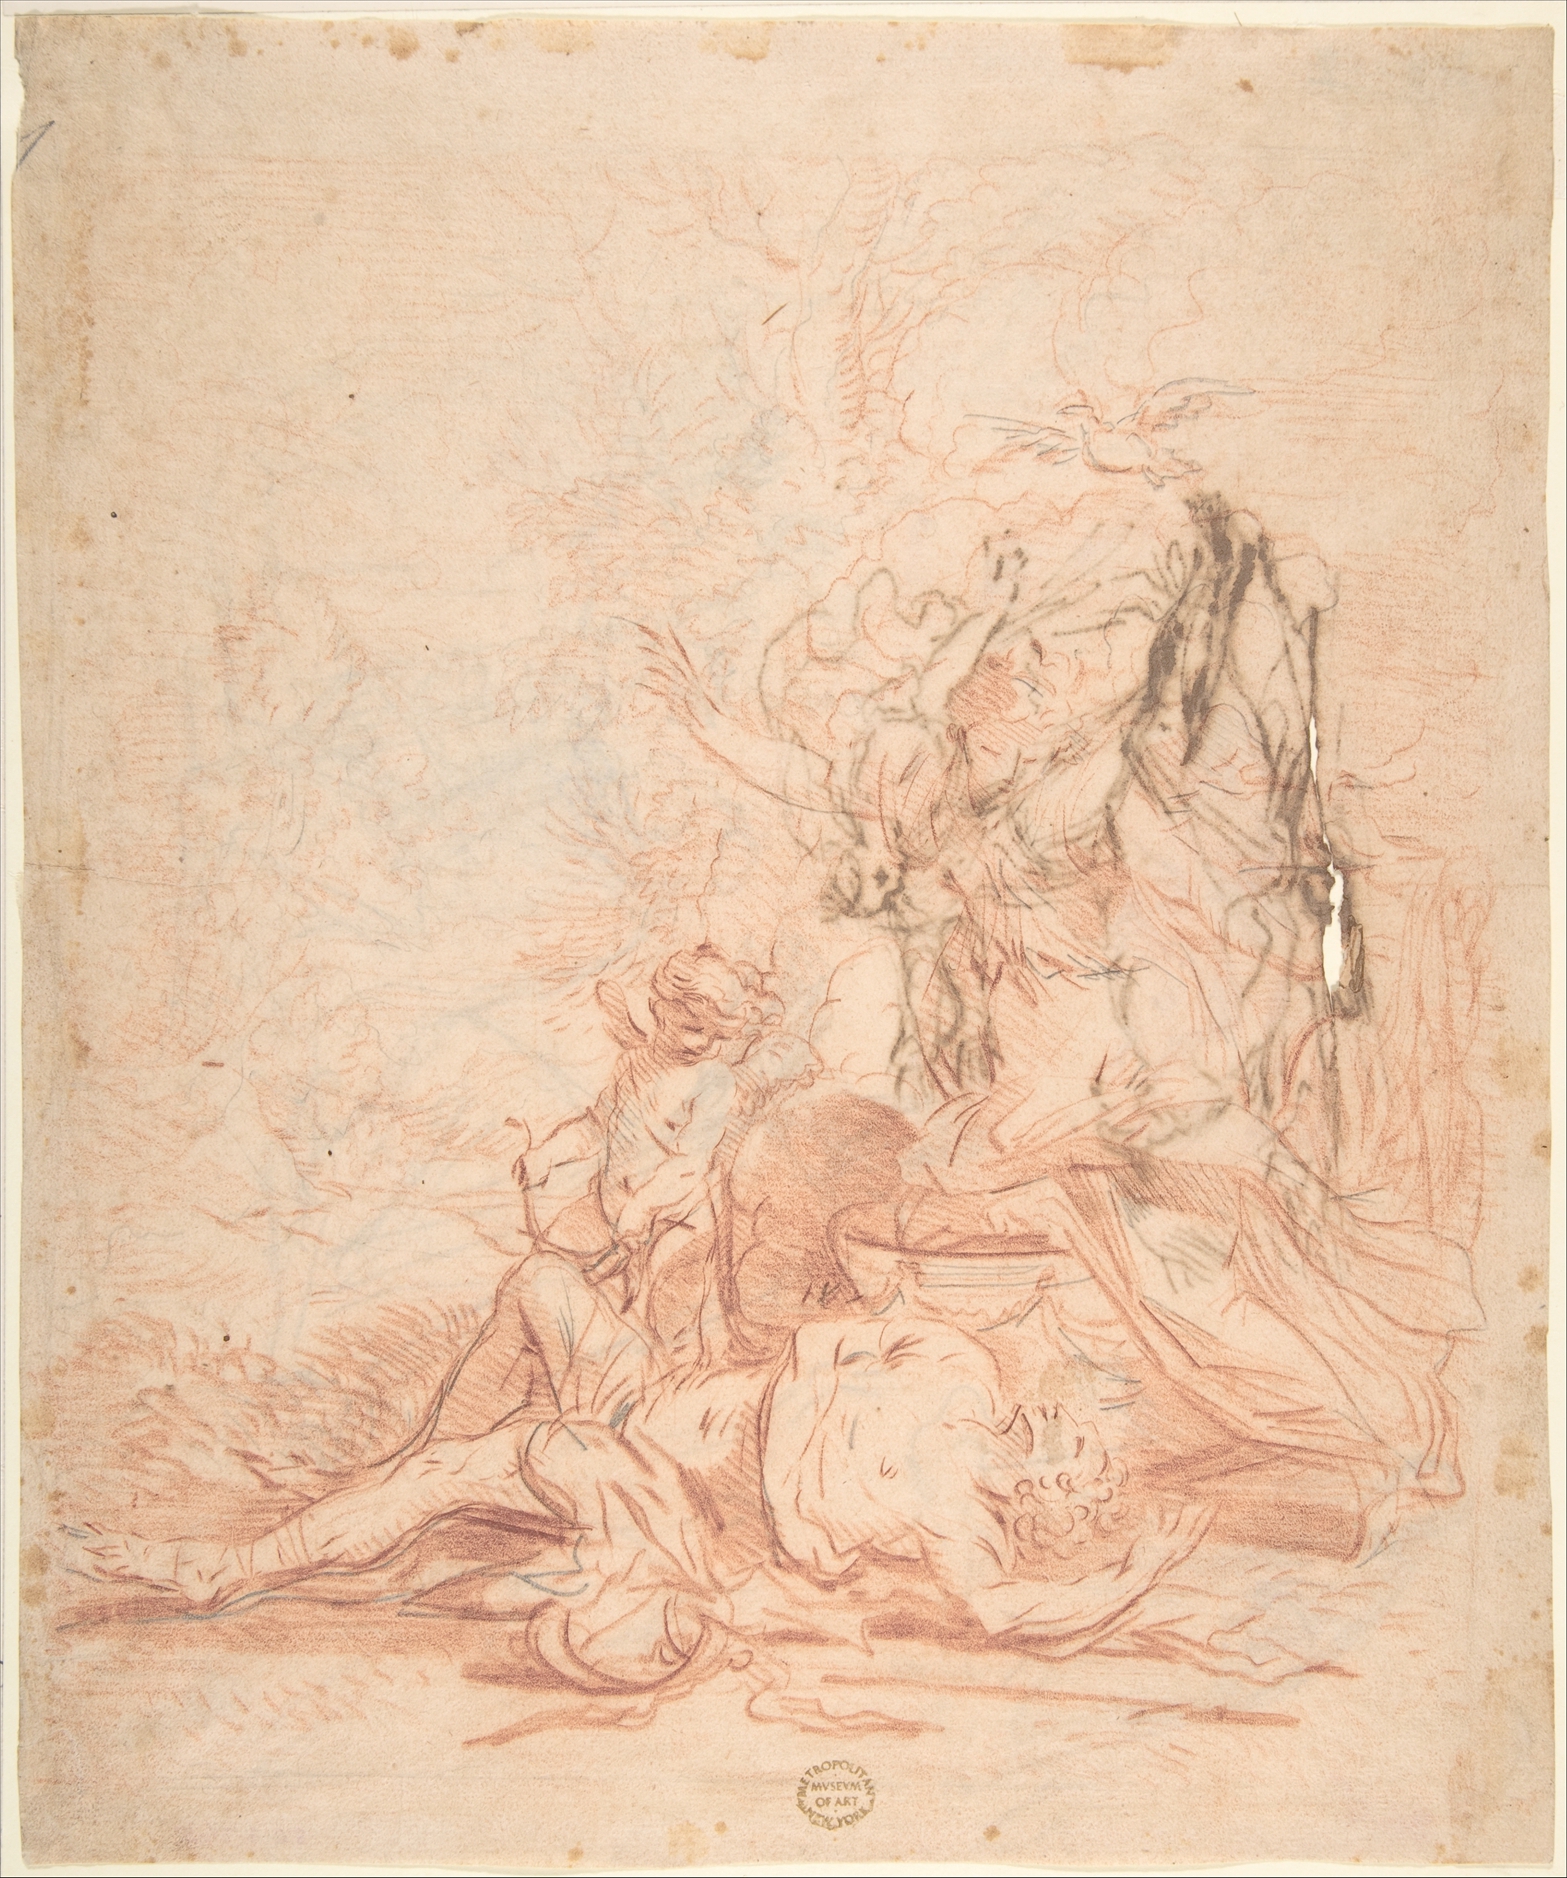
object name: drawing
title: Venus and the Dead Adonis (recto); Sketches of Venus and the Dead Adonis; several sketches of kneeling and standing figures (verso)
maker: anonymous, italian, roman-bolognese, 17th century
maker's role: artist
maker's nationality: italian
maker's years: 1600-1700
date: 1696-1770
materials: chalk, graphite, ink, paper, lead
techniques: pen, drawing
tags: adonis,venus,death